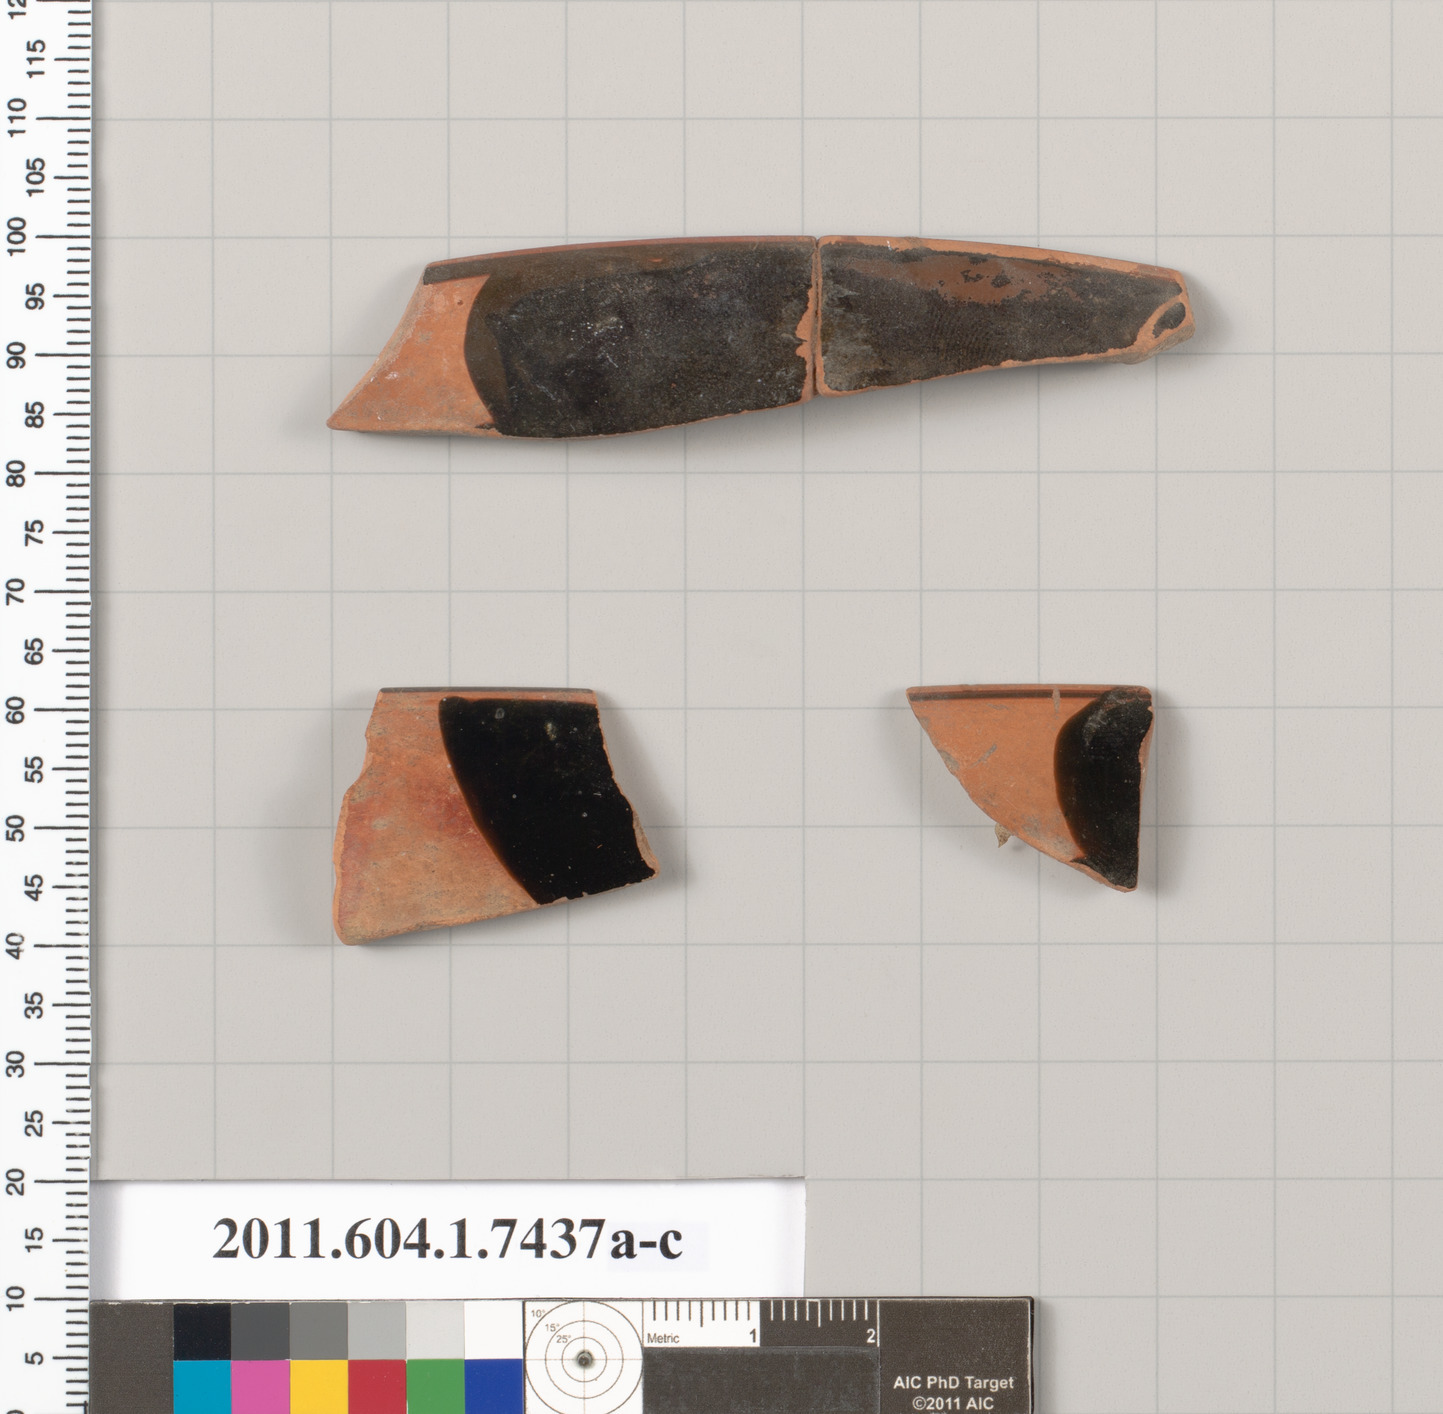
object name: kylix fragment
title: Terracotta rim fragments of kylikes (drinking cups)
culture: greek, attic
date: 490-470 BCE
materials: terracotta